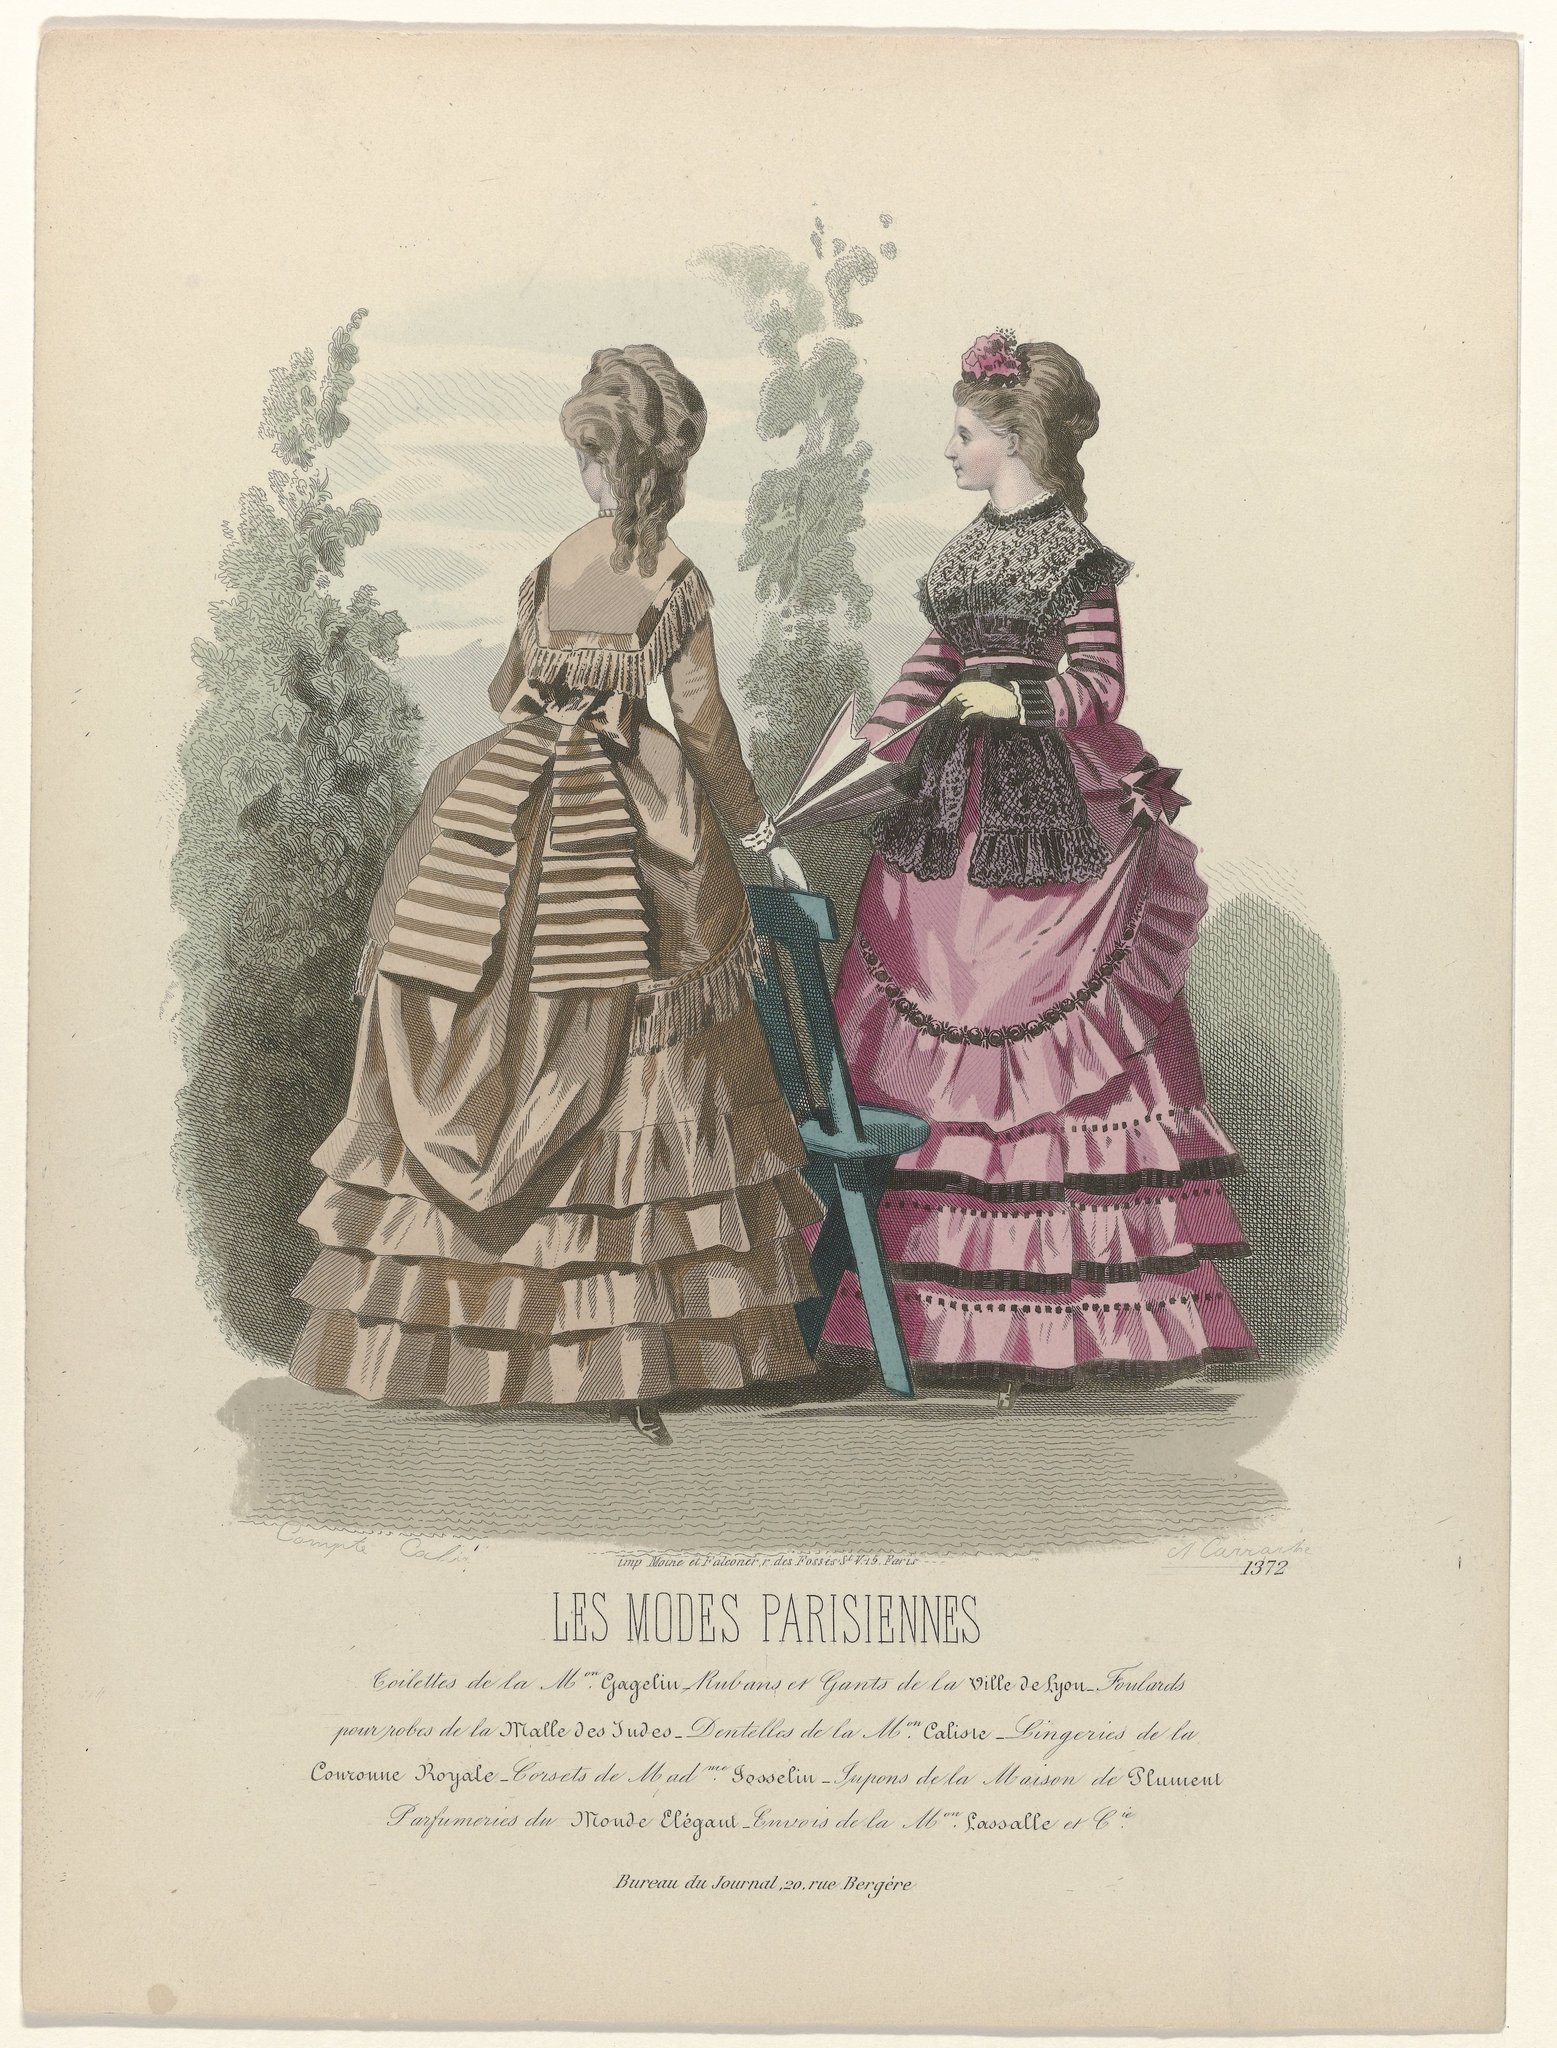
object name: fashion print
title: An Explosion of Fashion Magazines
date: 1867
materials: paper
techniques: engraving, hand coloring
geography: paris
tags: ornamental parts of clothing (+ women's clothes), lace (+ women's clothes), fashion plates, shoes, sandals (+ women's clothes), skirt (+ women's clothes), dress, gown (+ women's clothes), neck-gear ~ clothing (+ women's clothes), parasol, sunshade (+ women's clothes)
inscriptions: title: ‘Les Modes Parisiennes’, caption: ‘Toilettes de la M.on gagelin _ Rubans et Gants de la Ville de Lyon _ Foulards pour robes de la Malle des Indes _ Dentelles de la M.on Caliste _ Lingeries de la Couronne Royale _ Corsets de Mad.me Josselin _ Jupons de la Maison de Plument Parfumeries du Monde Élégant _ envois de la M.on Lassalle et C.ie’, address: ‘Bureau du Journal, 20, rue Bergére.’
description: Starting from the 1850s, fashion magazines became more affordable and acquired a wider readership. The invention of the sewing machine around 1850 made it easier for people to make their own clothes. Ready-made garments were now also on offer, with fashion plates providing vendor addresses, such as the Maison Gagelin in Paris.